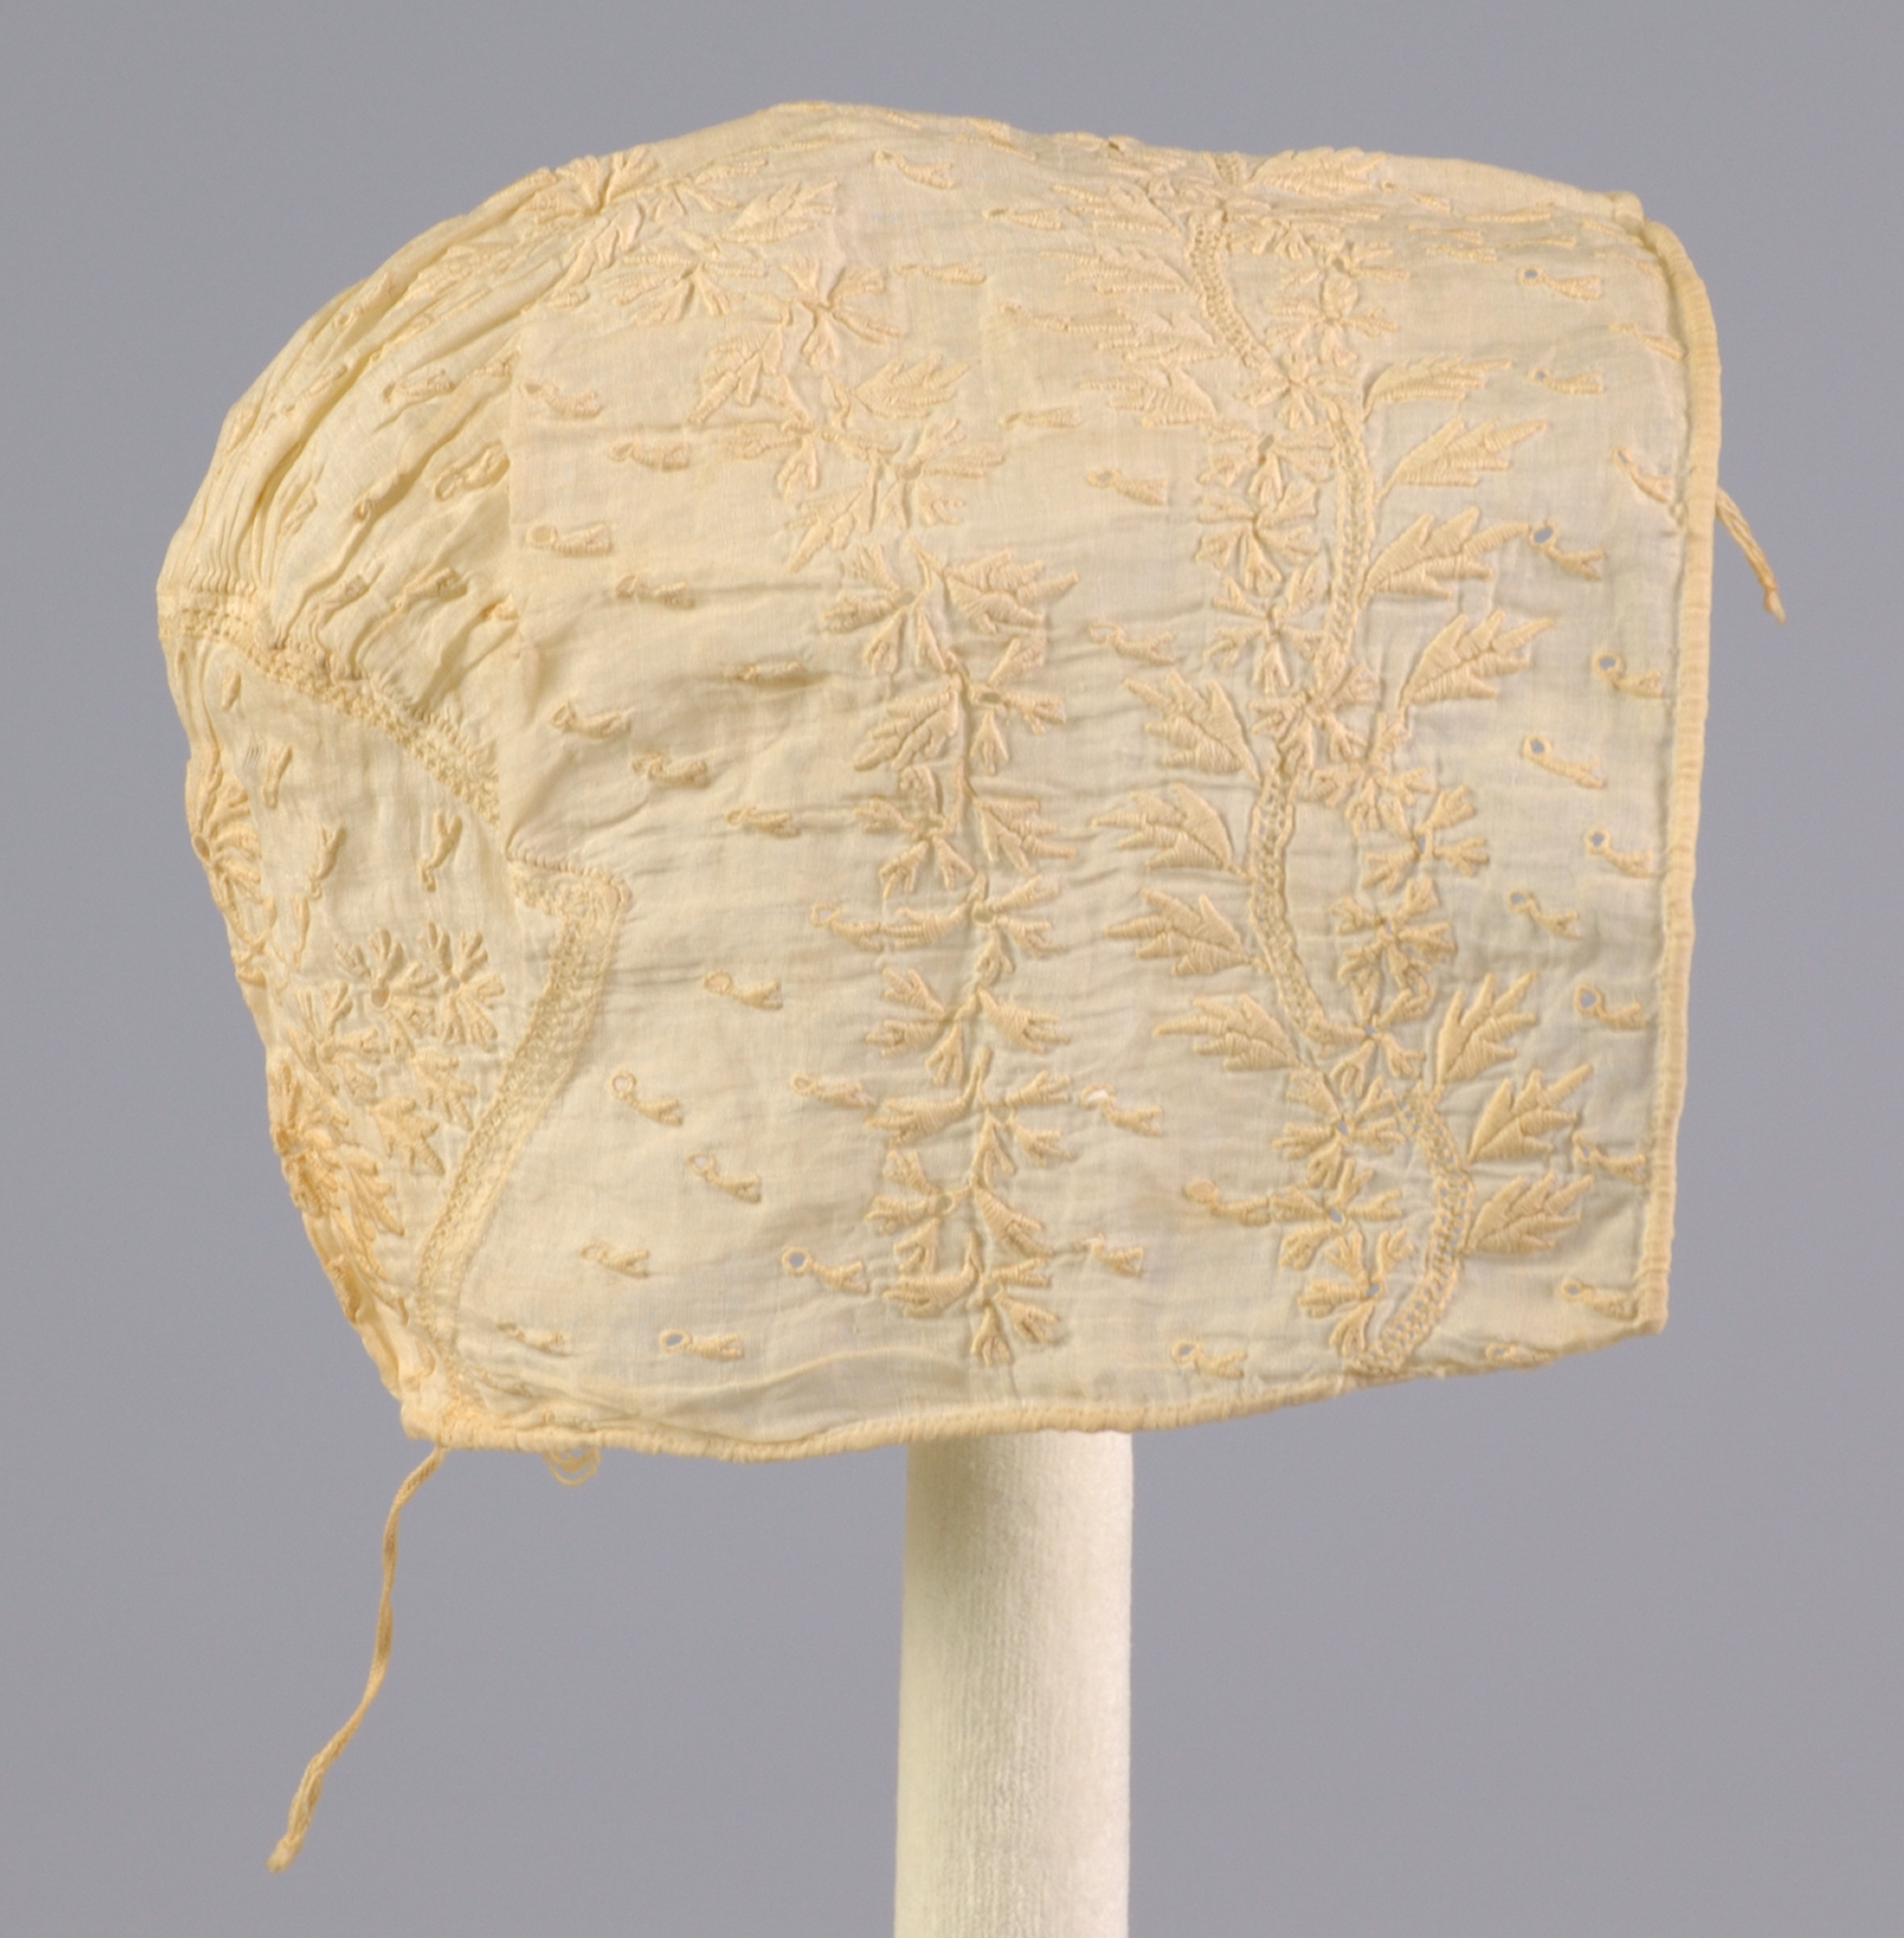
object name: cap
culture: american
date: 1813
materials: cotton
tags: flowers